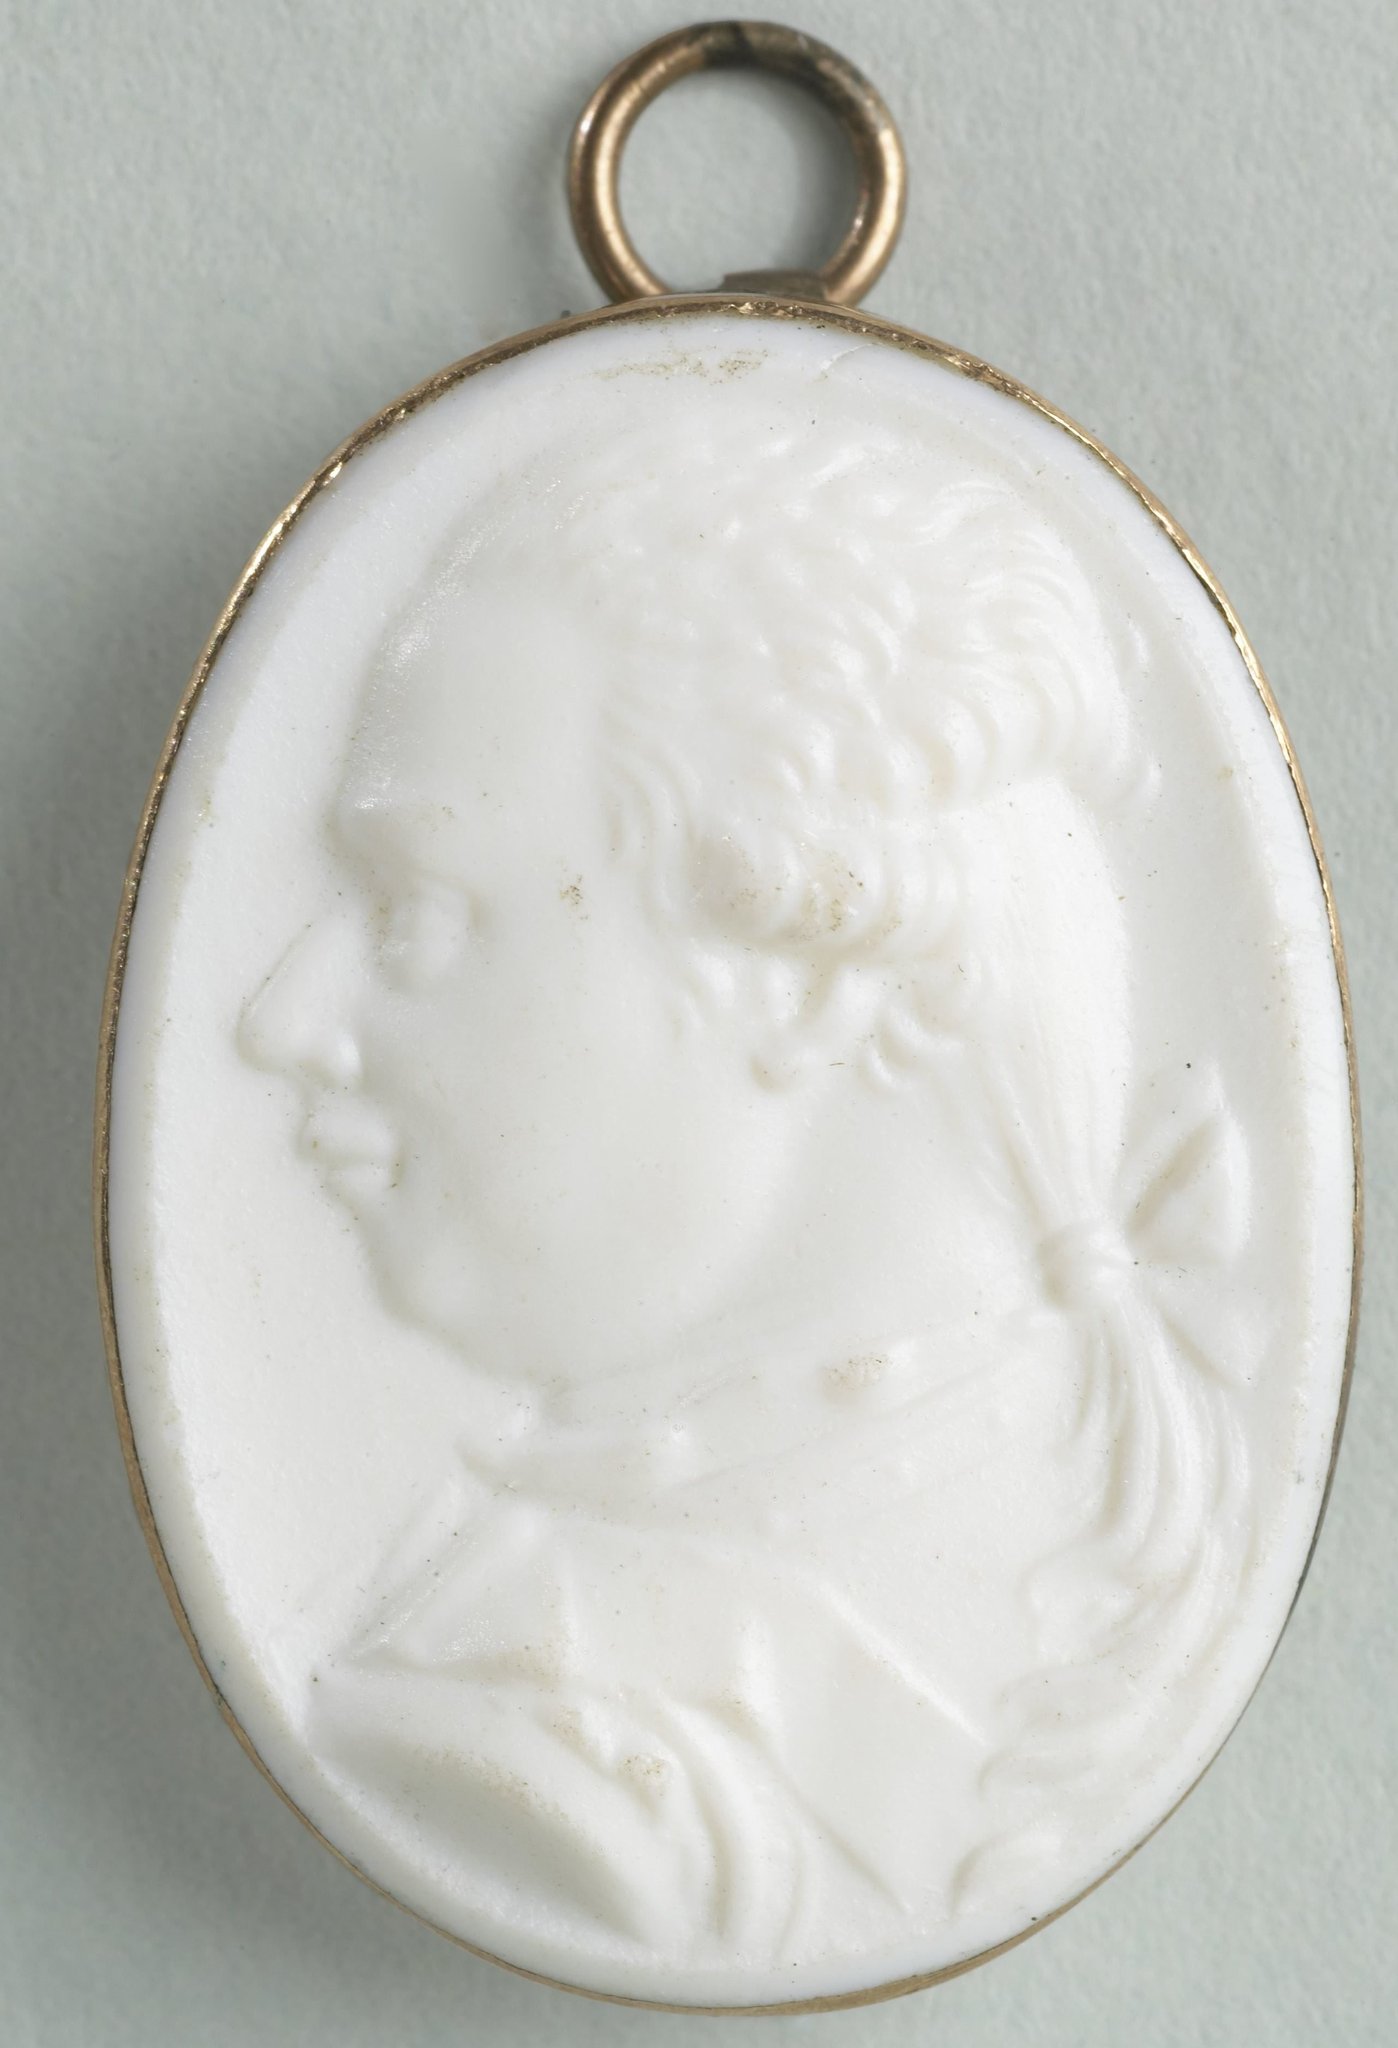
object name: portretmedaillon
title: Portret van Willem V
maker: Anonymous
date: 1775-1800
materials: porcelain, silver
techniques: firing, forging, gilding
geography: berlin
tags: the hague, william v (prince of orange), historical persons, netherlands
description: Ovaal miniatuurportret in basrelief, wit porselein, borstbeeld van een man (Willem V), gewend naar links, haar in een staart met strik. In verguld zilveren lijstje, achterzijde open, met draagoog en draagring.